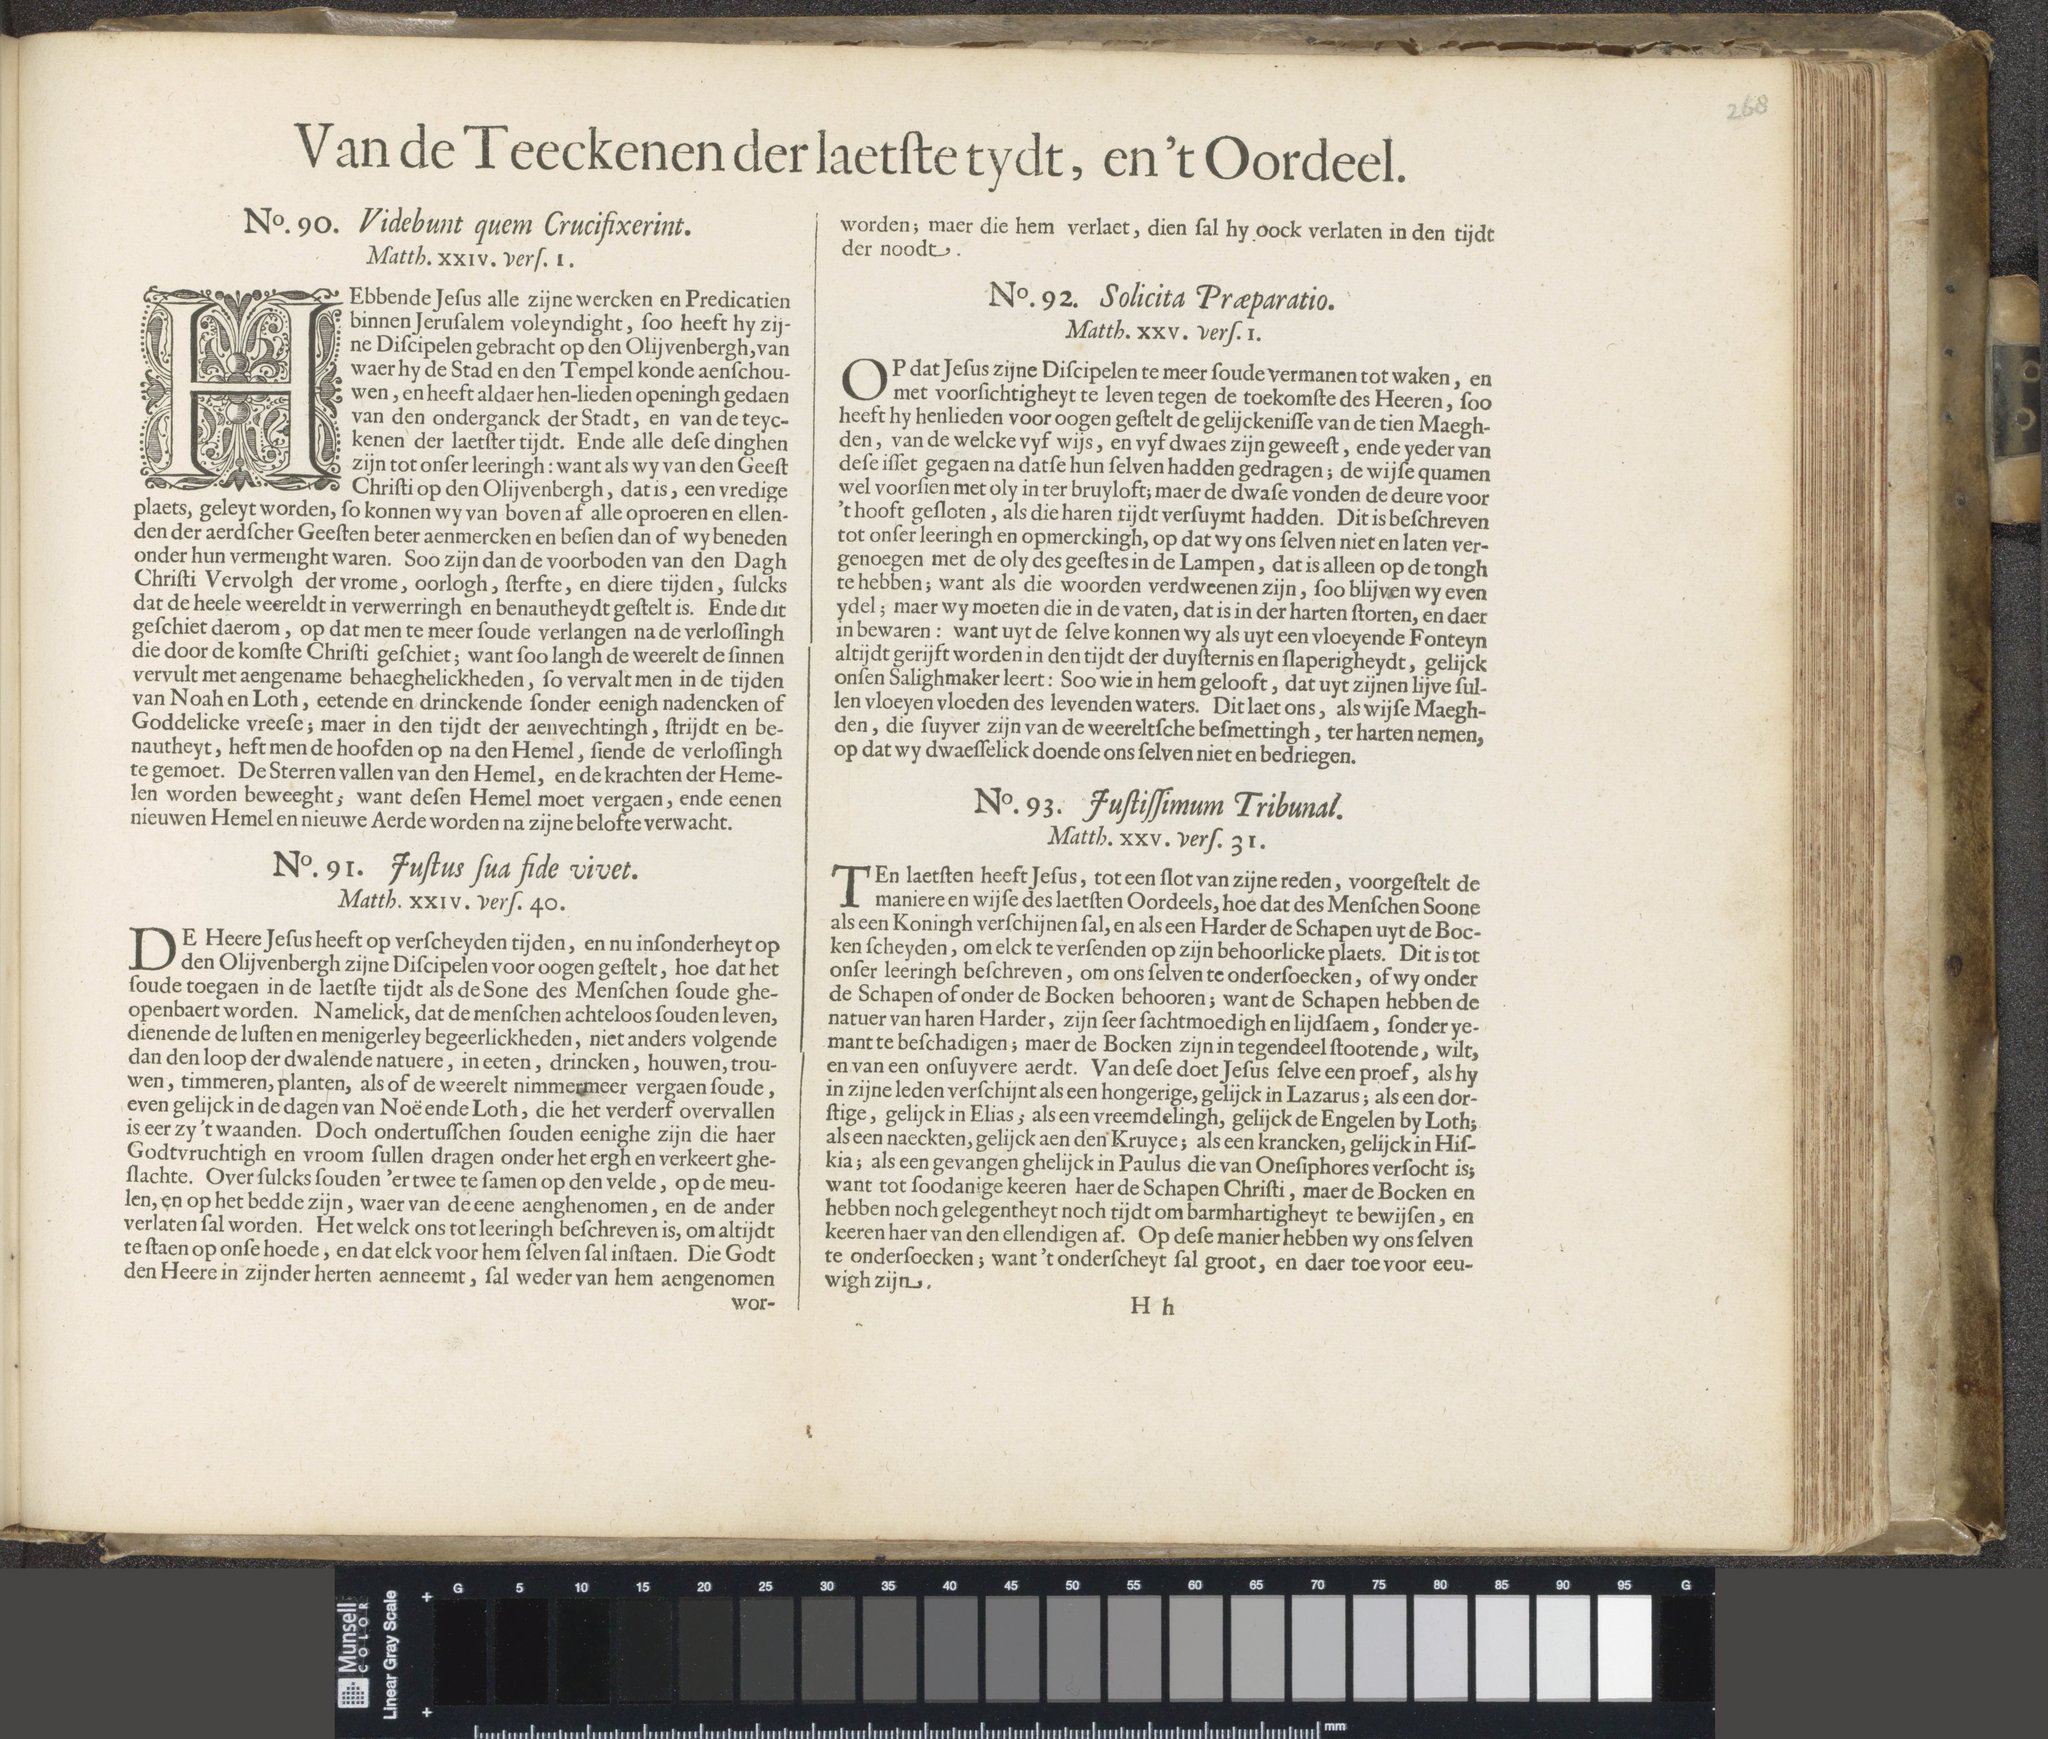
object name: album leaf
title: Den Grooten Emblemata Sacra, bestaande in meer dan vier hondert bybelsche figuren, zoo des Ouden als des Nieuwen Testaments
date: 1653-1654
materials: paper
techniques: letterpress printing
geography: amsterdam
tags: initial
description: Vier toelichtingen bij voorstellingen over de aankondiging van het Laatste Oordeel, genummerd 90 tot en met 93. De tekst vangt aan met een gedecoreerde initiaal H. Het blad maakt deel uit van een album.